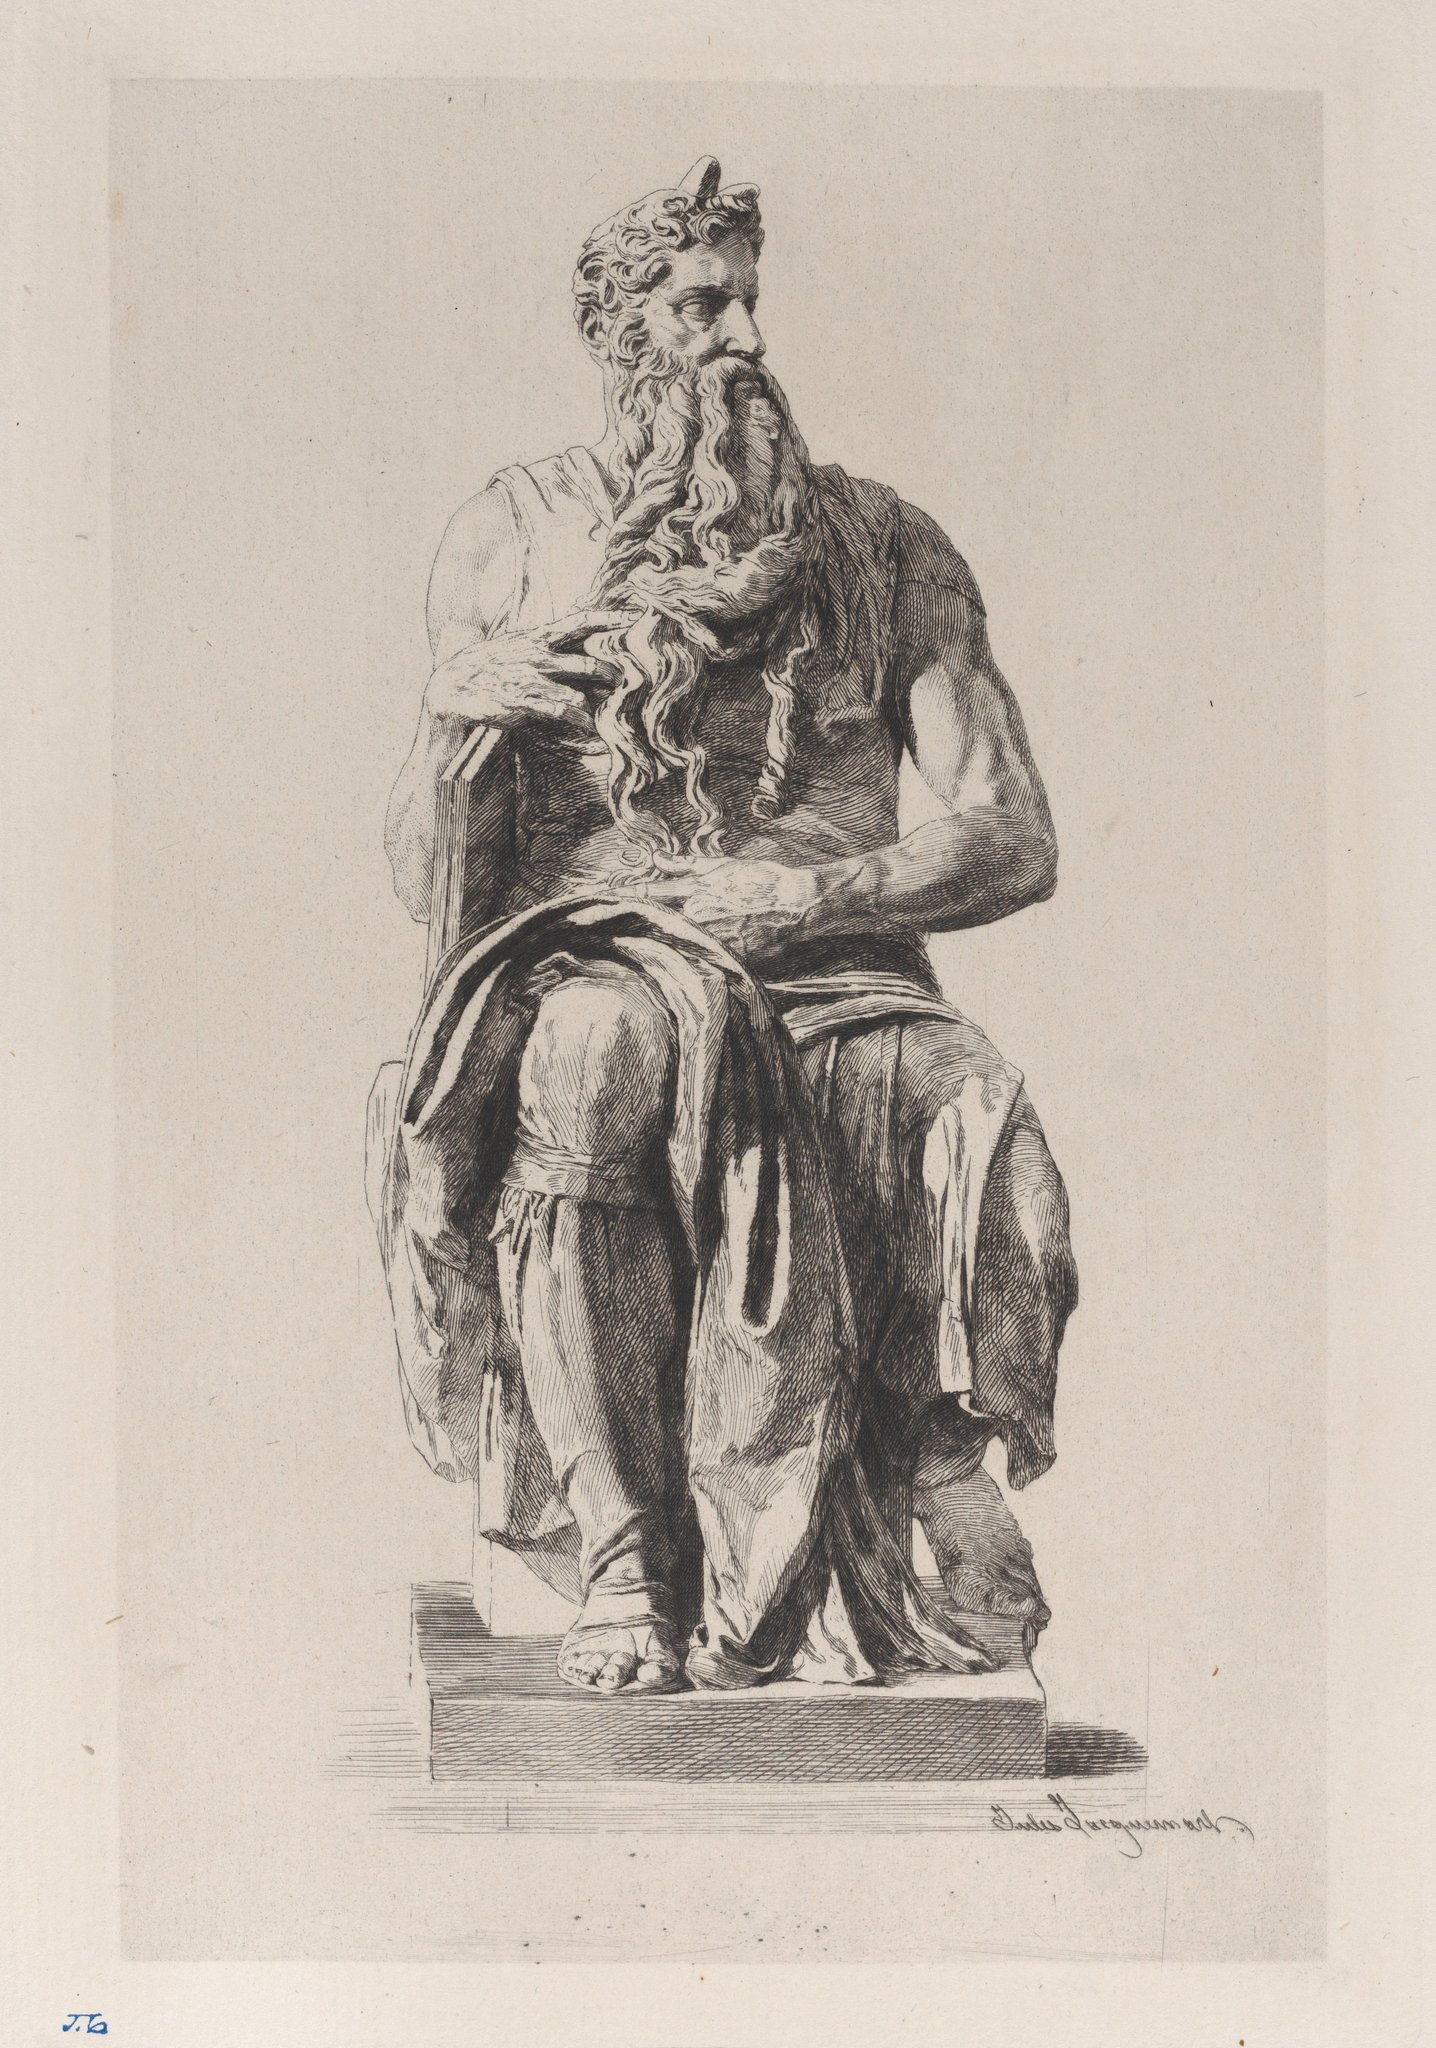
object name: print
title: Moses, after Michelangelo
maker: jules-ferdinand jacquemart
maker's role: artist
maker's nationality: french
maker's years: 1837-1880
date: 1875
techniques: etching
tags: sculpture,men,moses